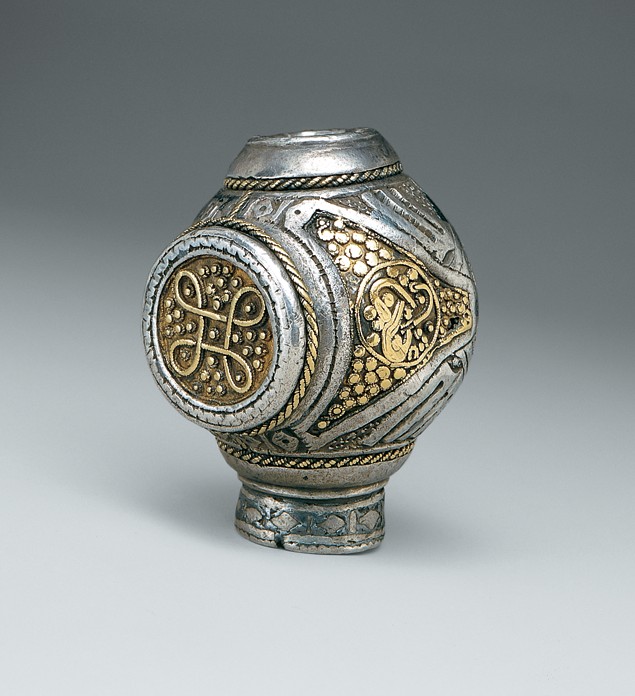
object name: brooch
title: Terminal for an Open Ring Brooch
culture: viking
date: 950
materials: gold, niello, silver